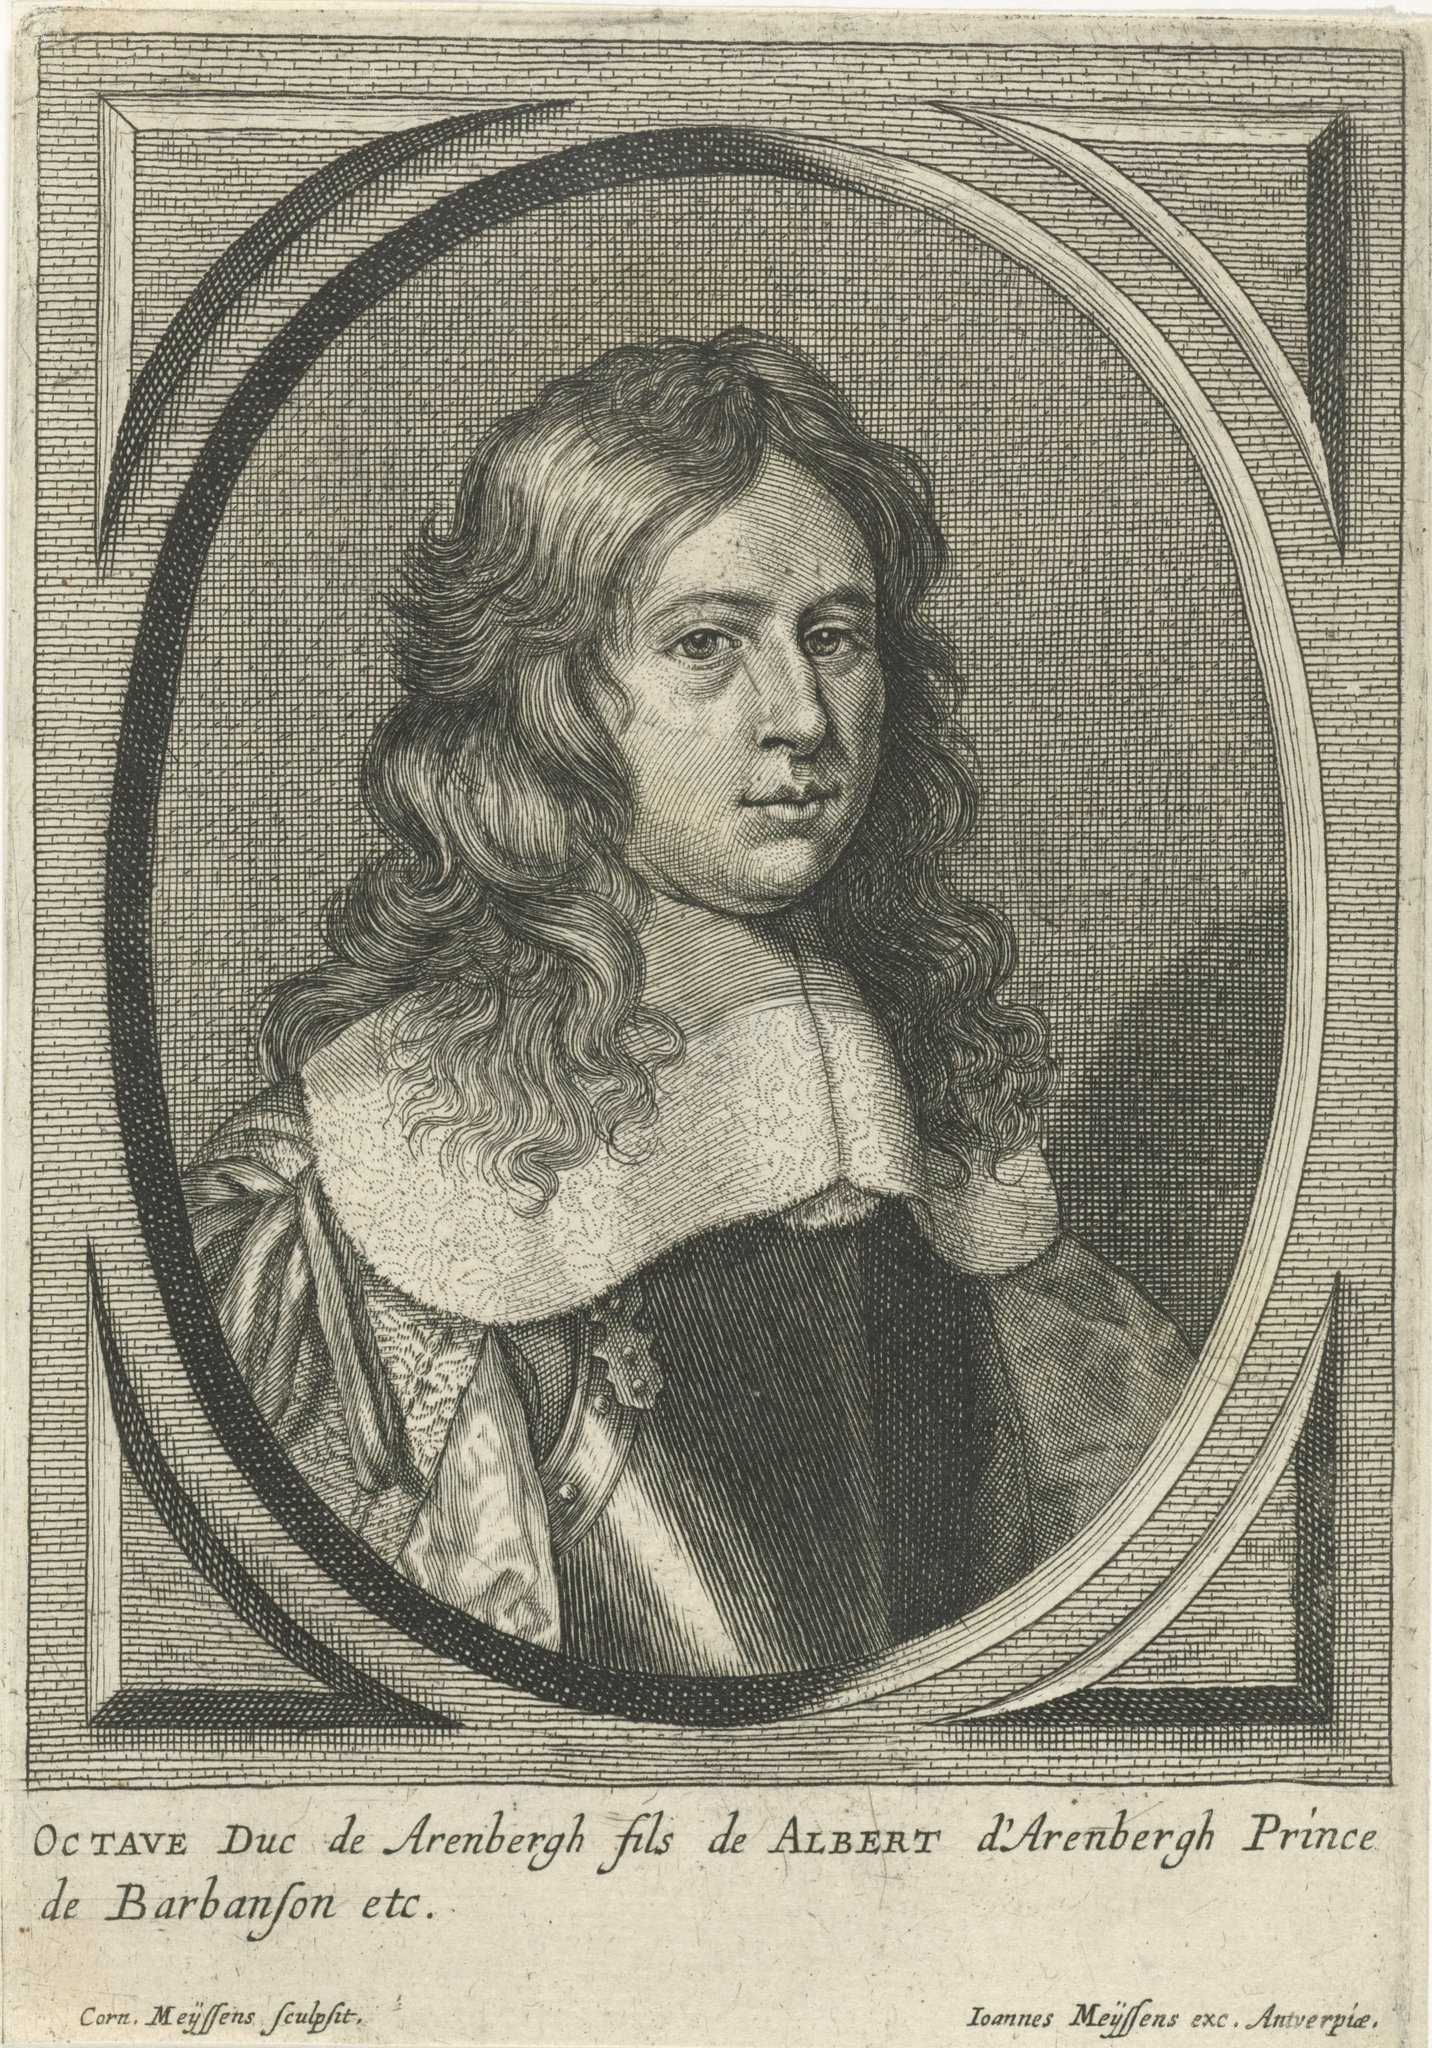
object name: print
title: Portret van Octave de Ligne, prins van Arenberg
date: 1650-1670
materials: paper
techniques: engraving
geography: antwerp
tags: octave de ligne (prins van arenberg)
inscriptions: collector's mark: Lugt 2228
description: Portret van Octave de Ligne, prins van Arenberg, zoon van Albert de Ligne.